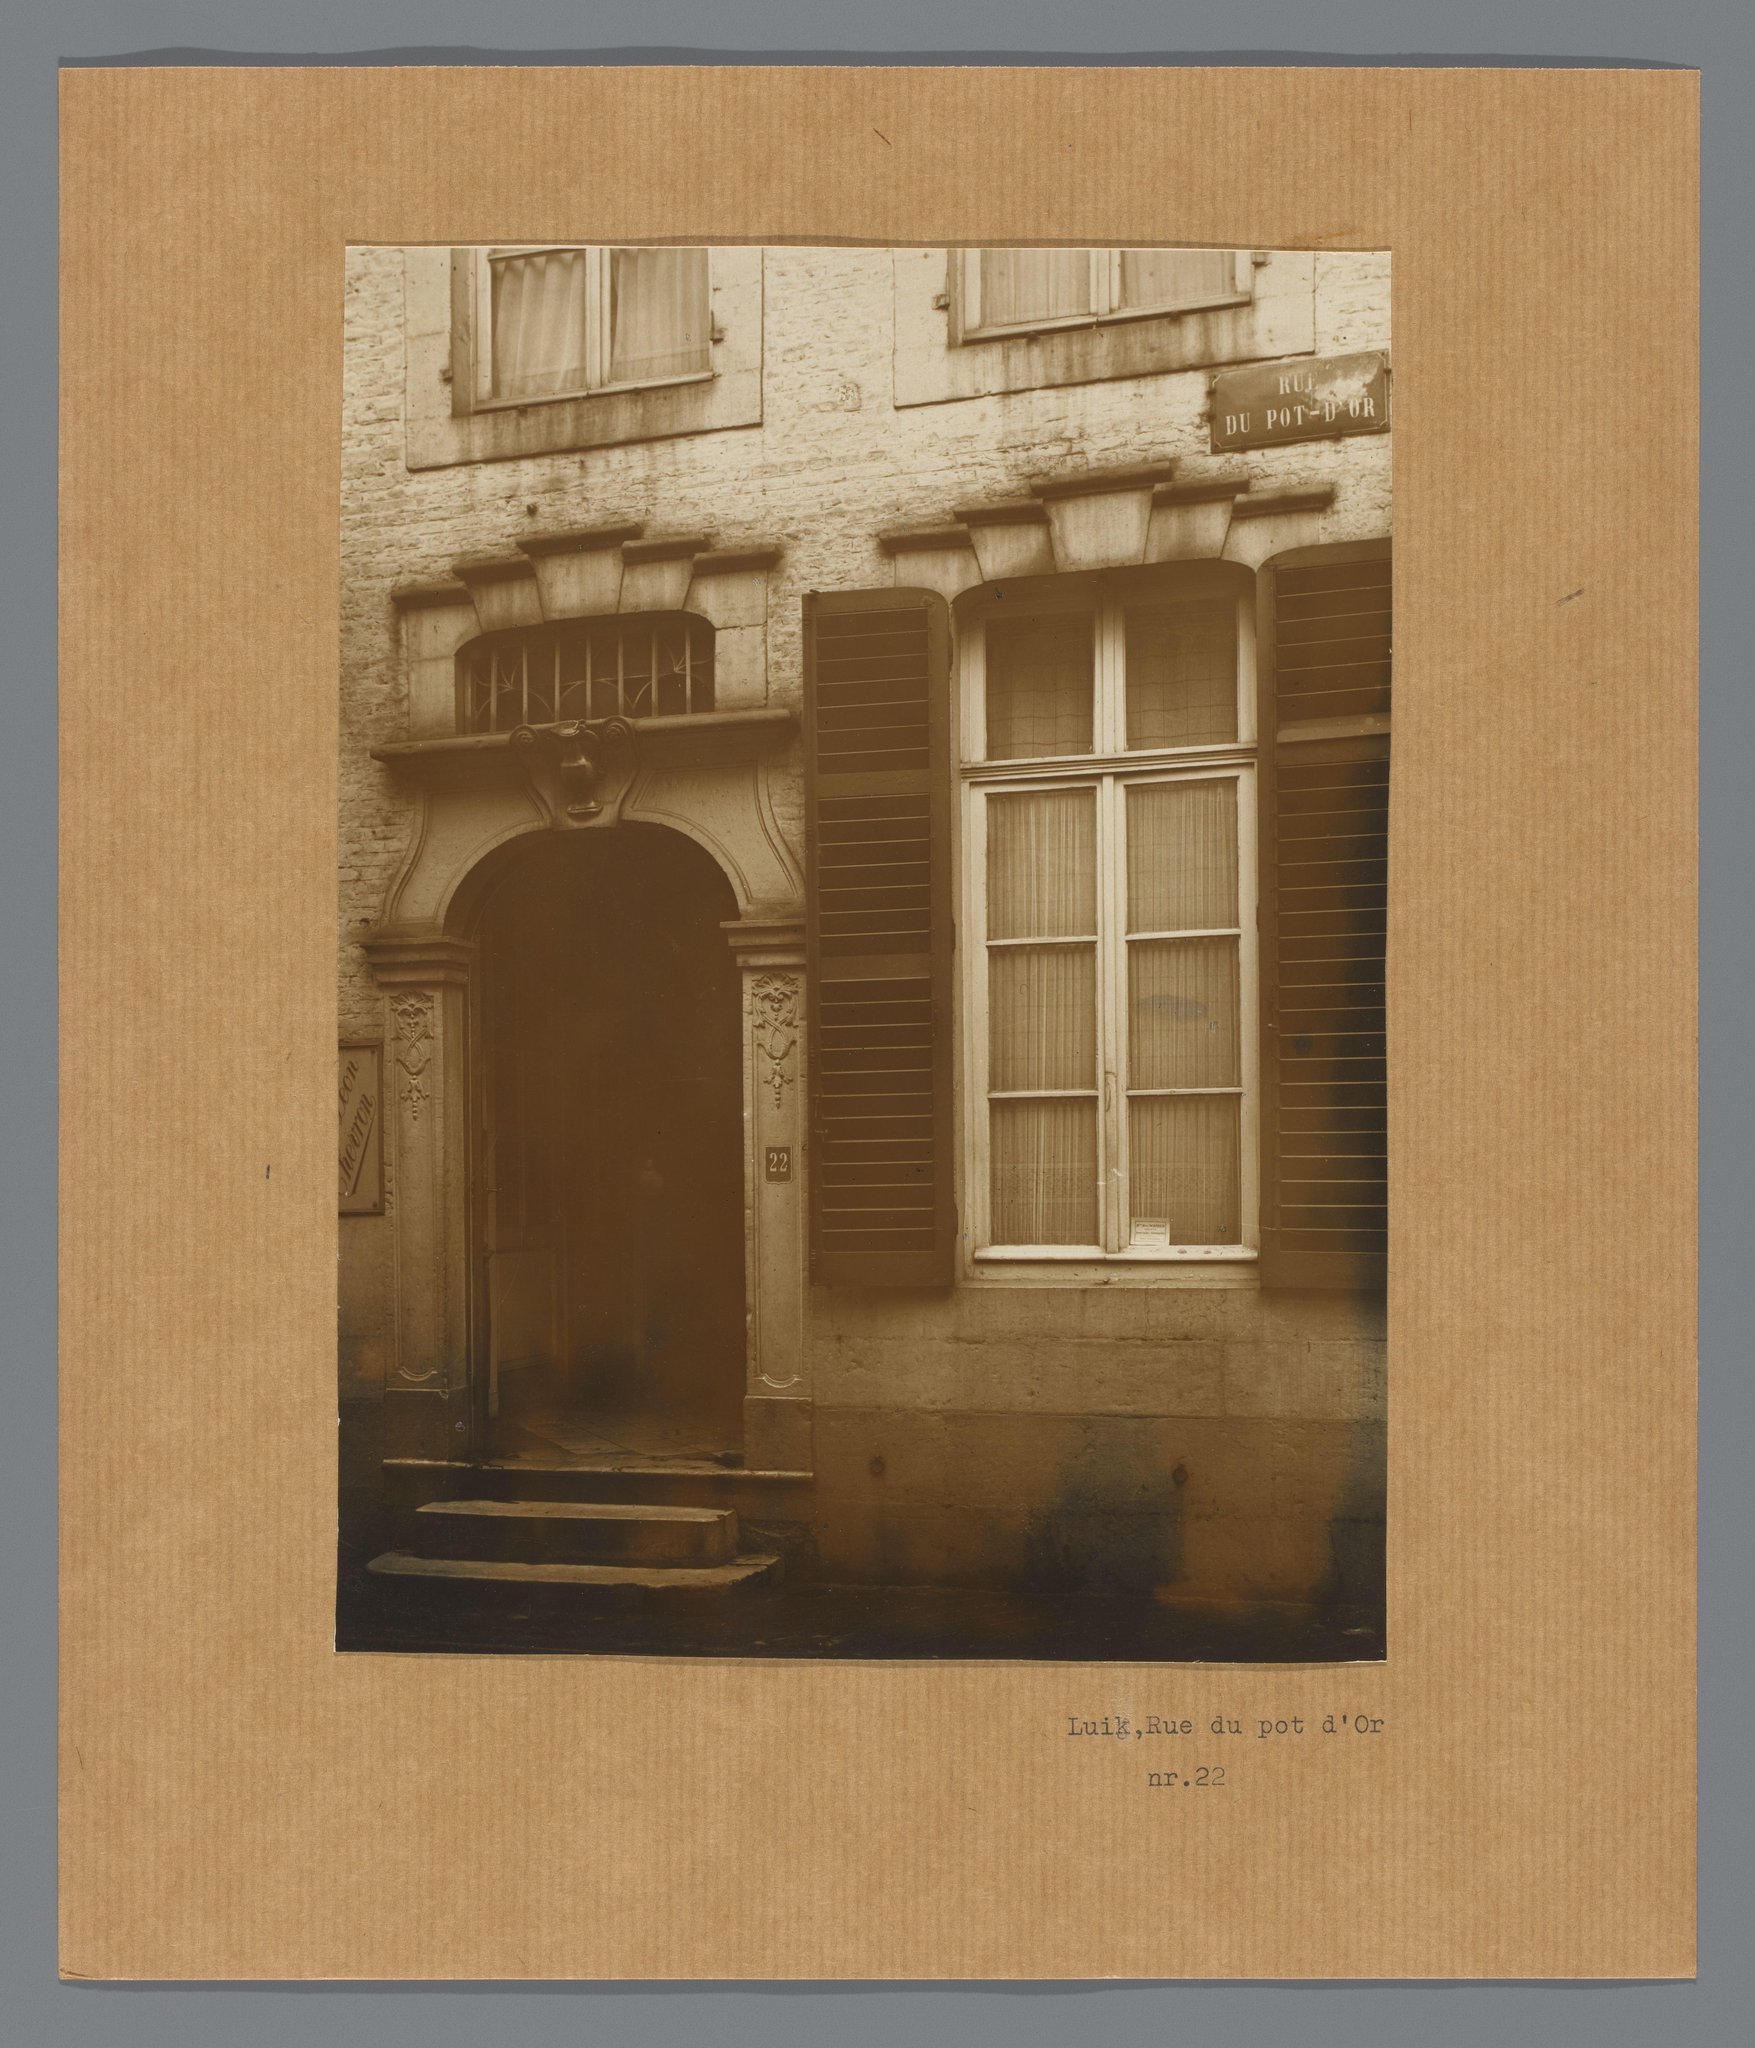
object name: photograph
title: Liege. Rue du pot d'Or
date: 1880-1930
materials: photographic support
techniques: gelatin silver print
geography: darmstadt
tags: liège